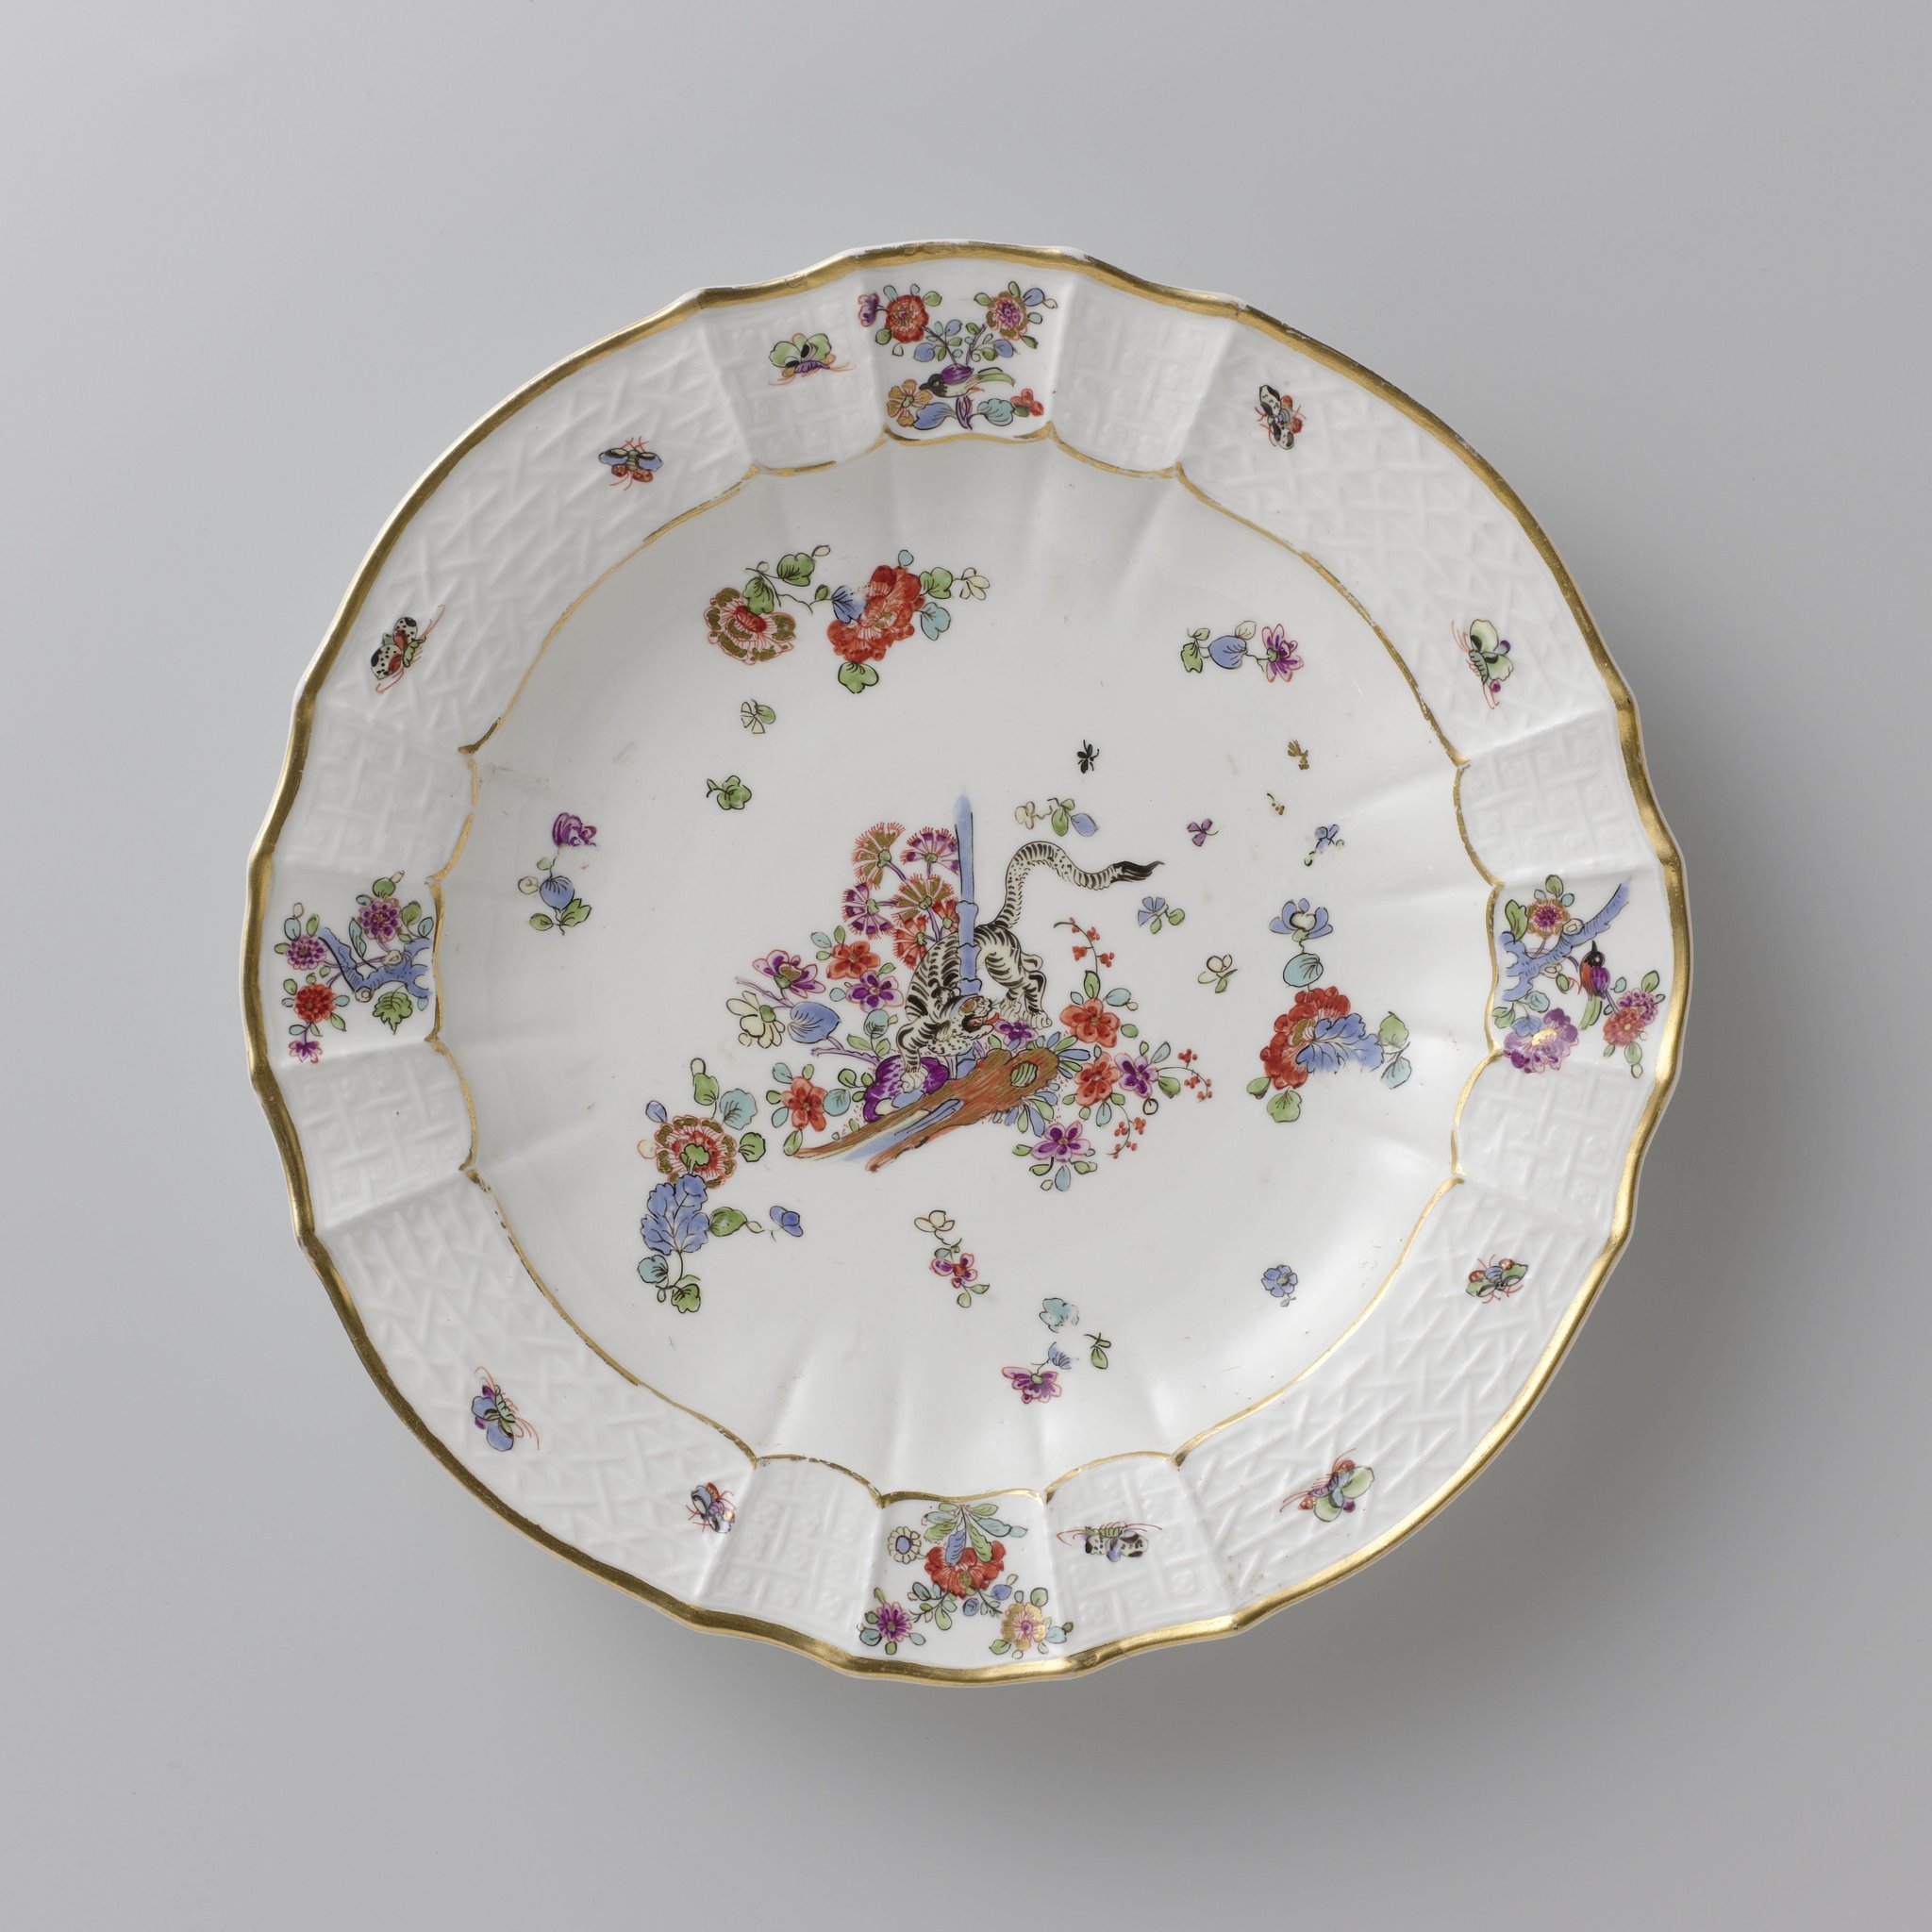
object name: plate dish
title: Rond bord, veelkleurig beschilderd met een Kakiemon-decor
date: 1740-1745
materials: porcelain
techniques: painted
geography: meissen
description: Rond bord van beschilderd porselein. Het bord is geribd en heeft een geschulpte rand. Het bord is beschilderd met een tijger die om een blauwe bamboestengel tussen bloemen is gedraaid, gestrooide Indianische Blumen, vlinders en takken waarop vogels. De rand is versierd met het 'Altbrandenstein'-patroon. Het bord is gemerkt.